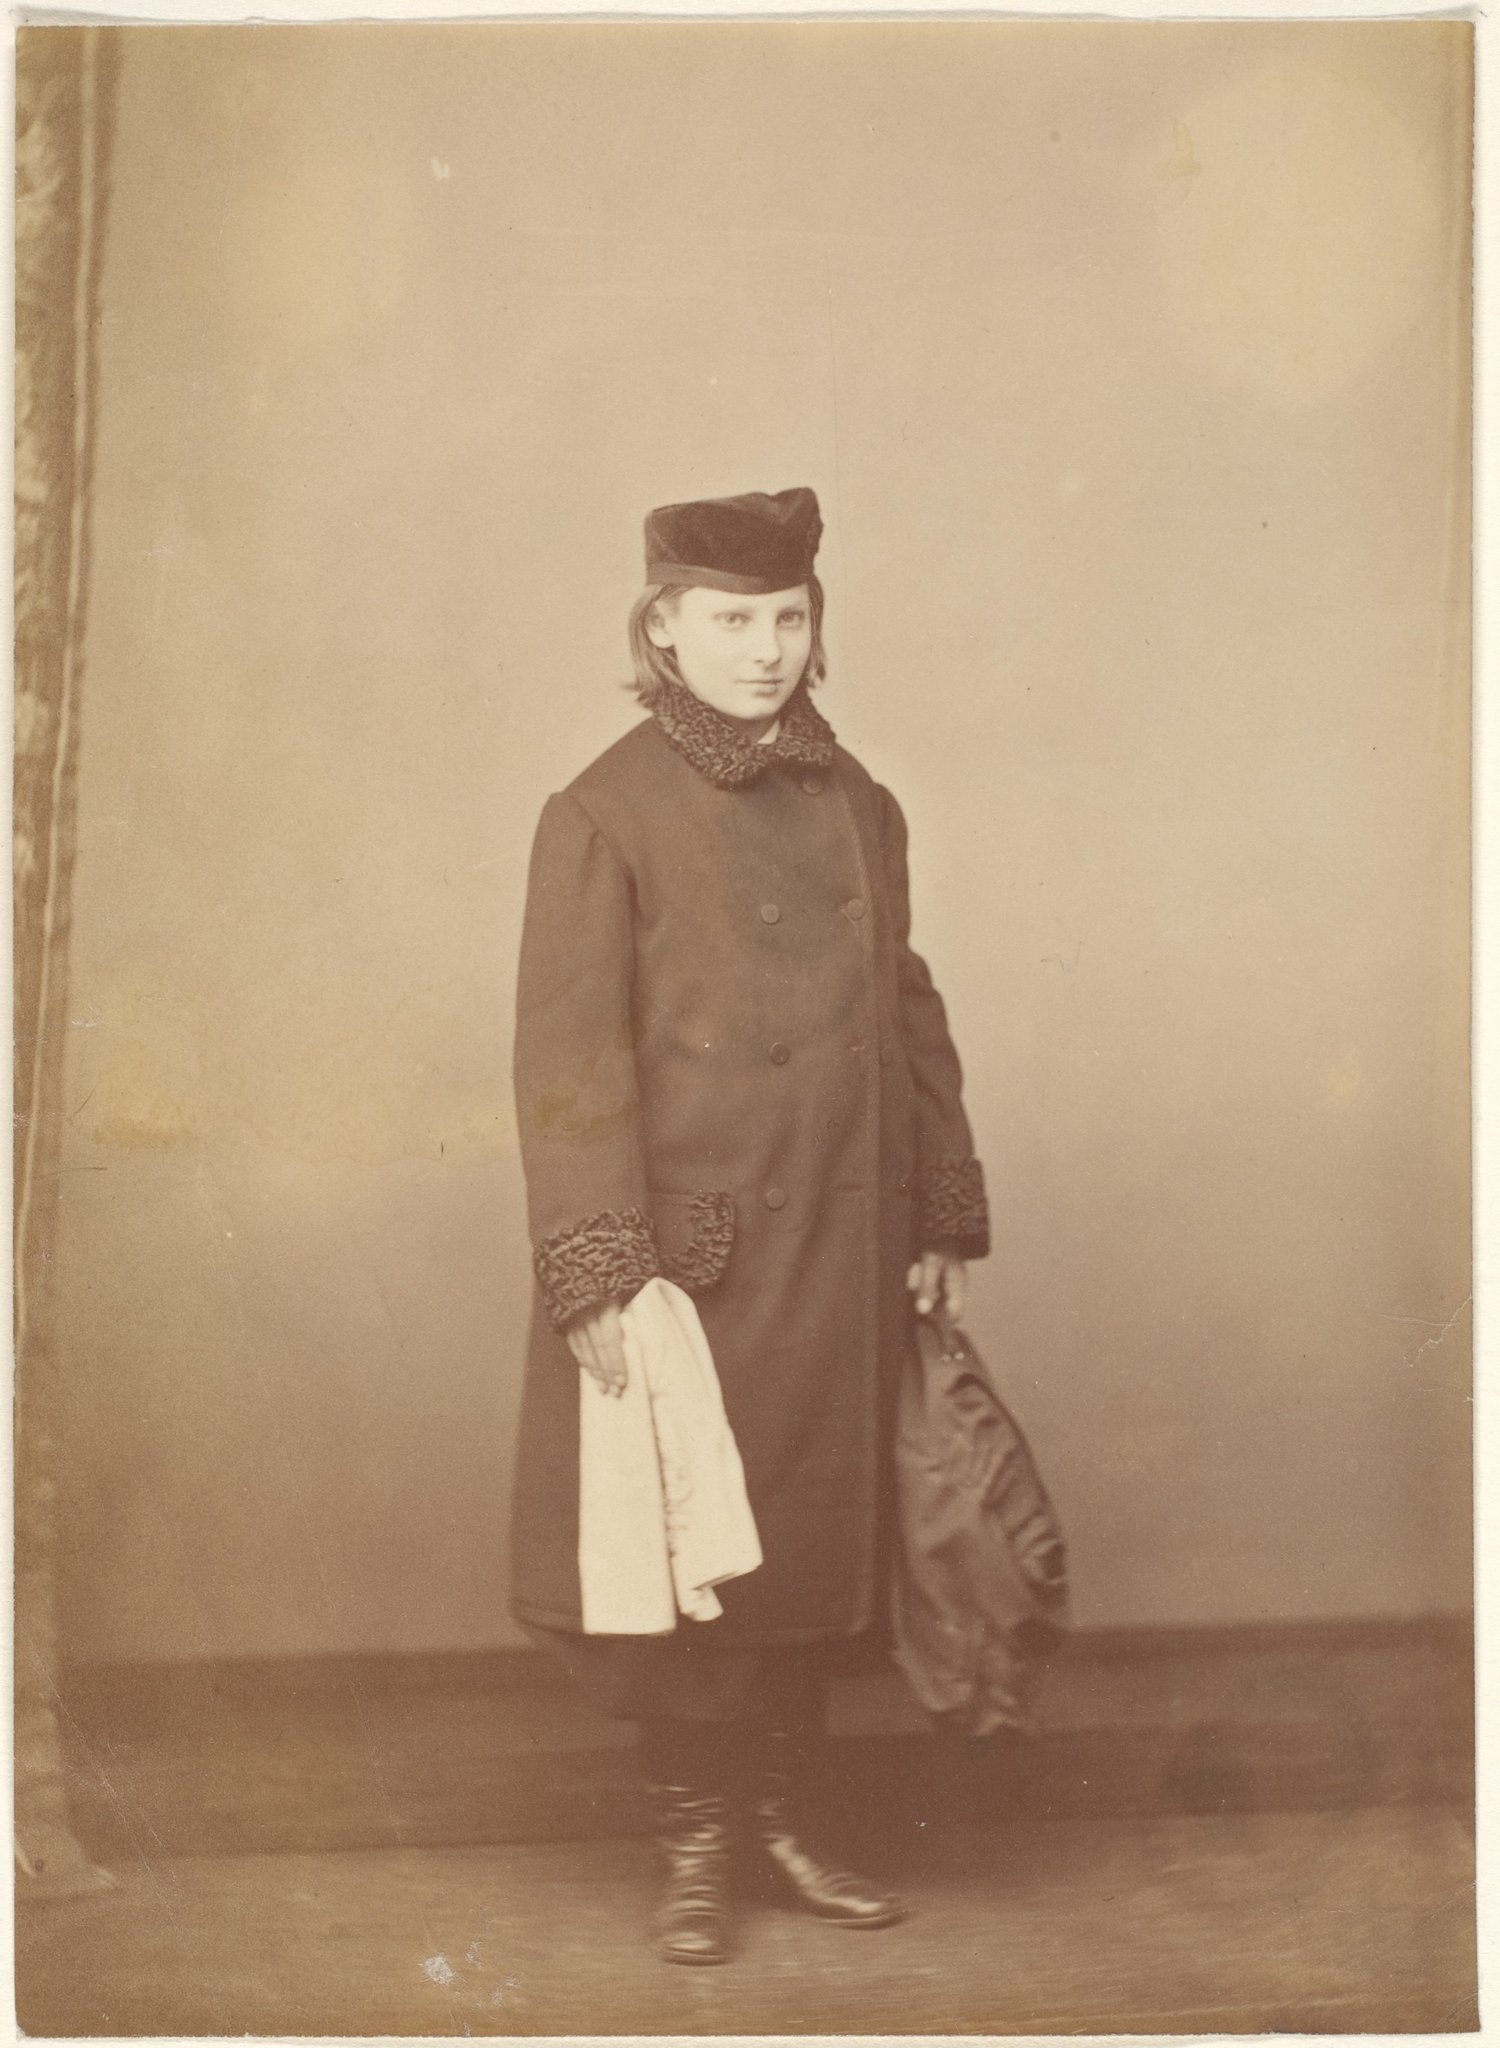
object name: photograph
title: Le Grand Russe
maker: pierre-louis pierson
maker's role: artist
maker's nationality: french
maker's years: 1822-1913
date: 1860-1869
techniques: albumen silver print, glass negative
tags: children,portraits